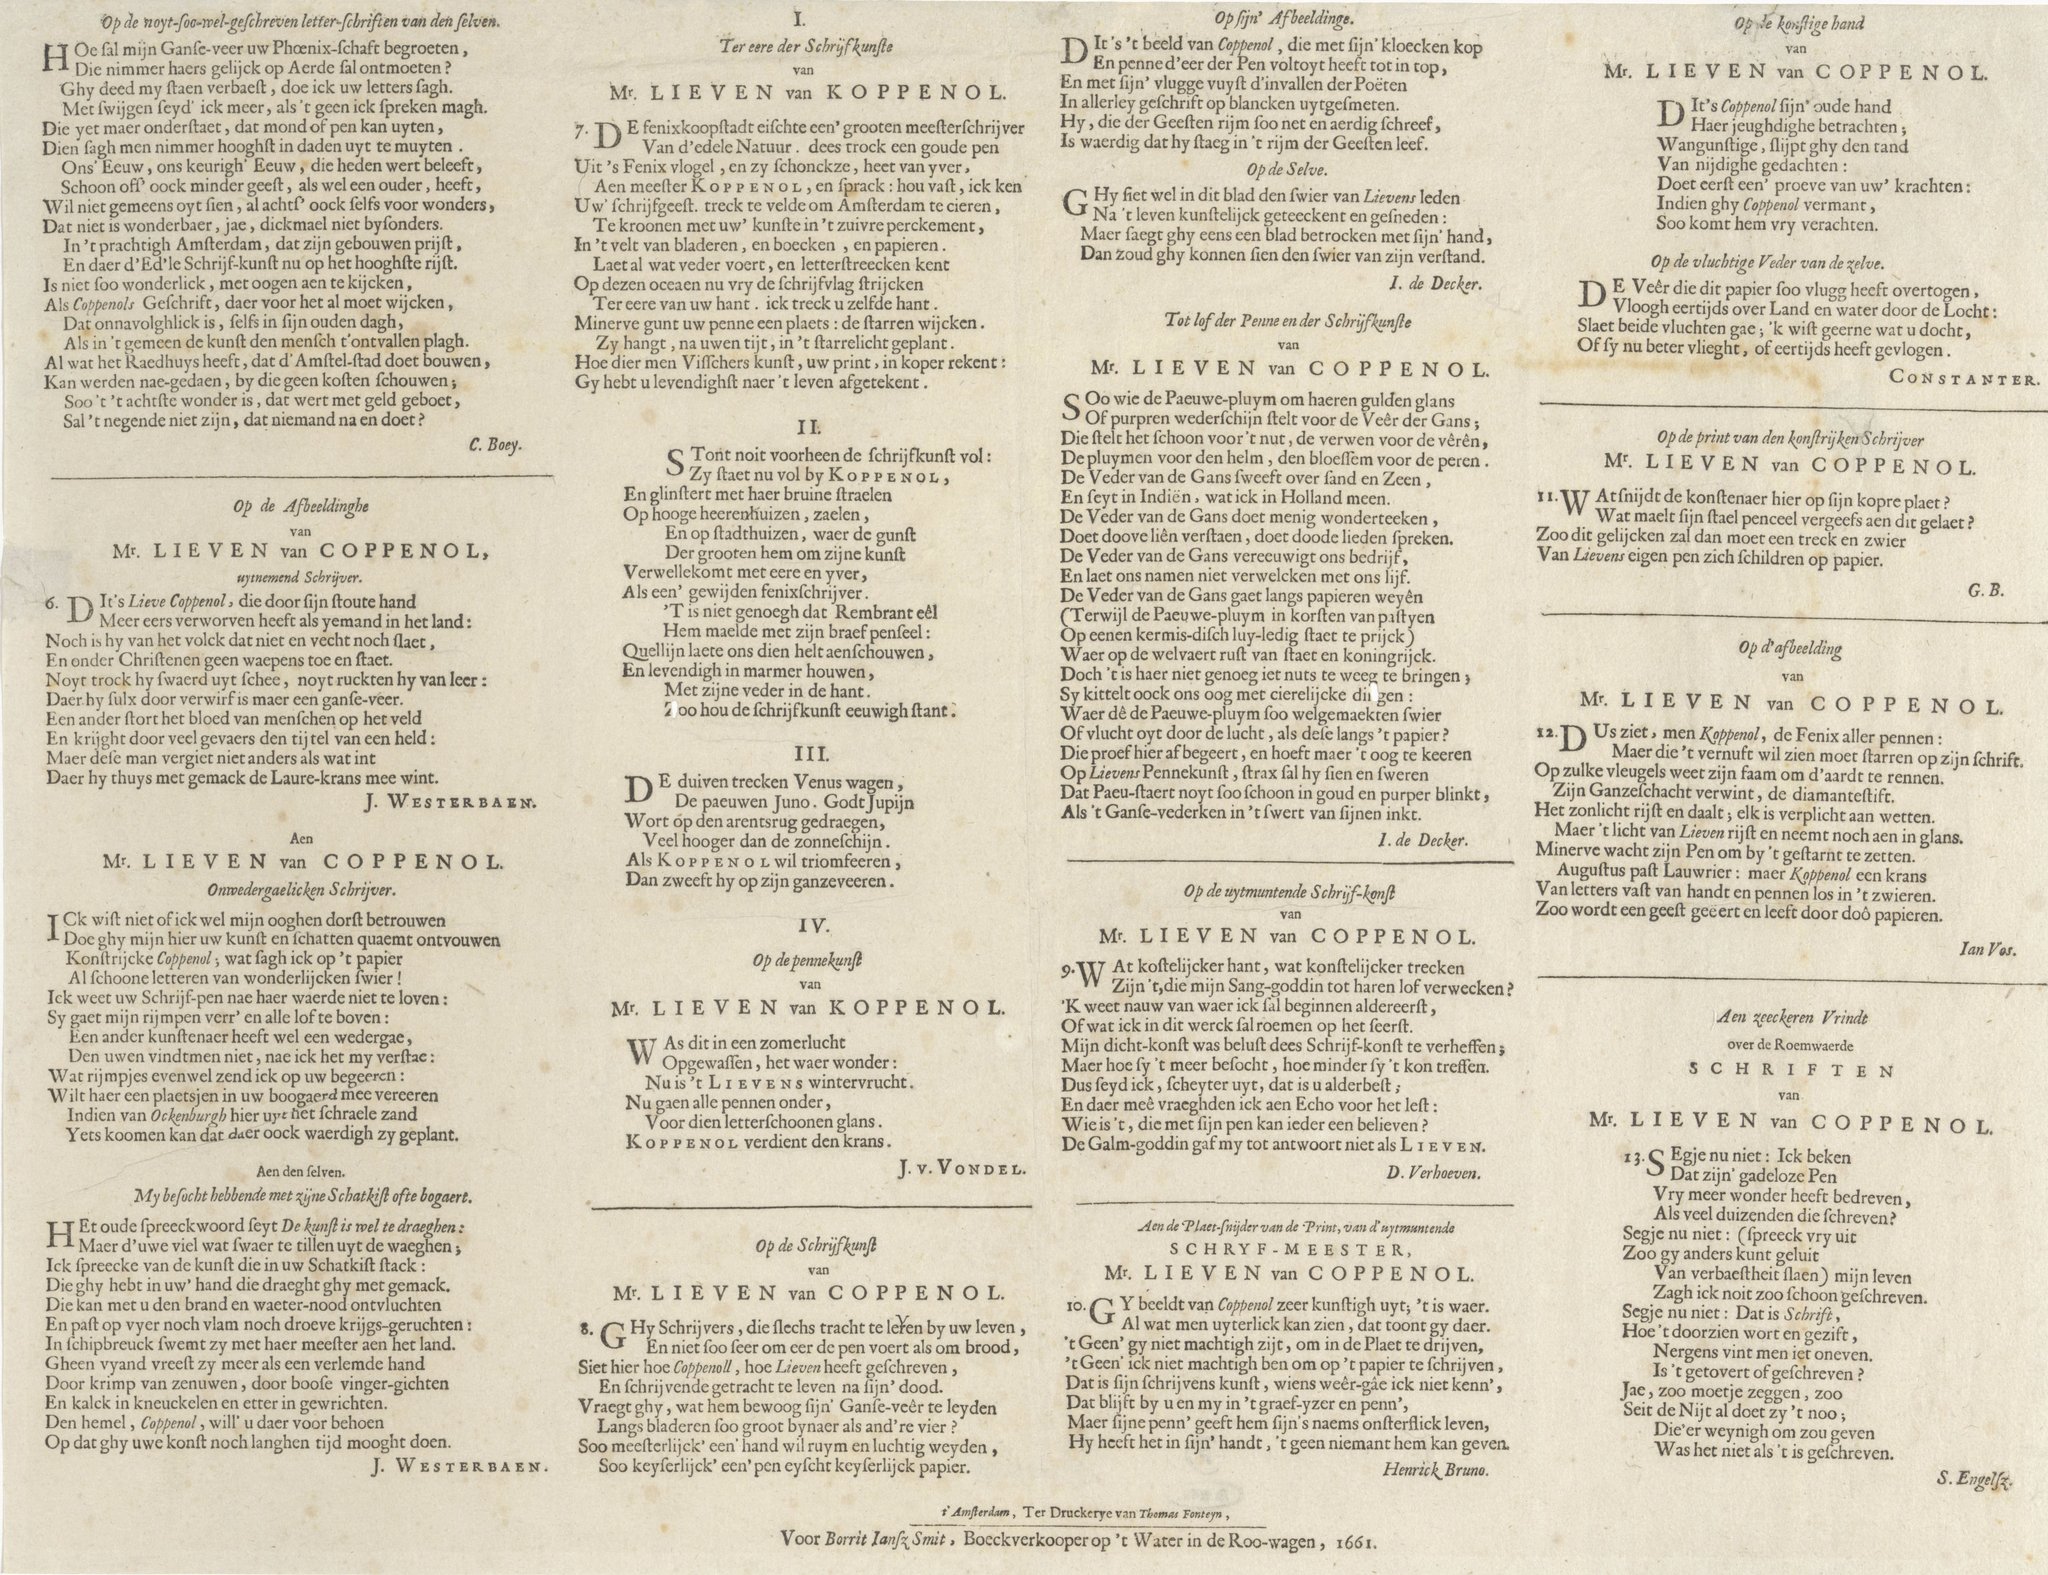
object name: text sheet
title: Lofgedichten van diverse schrijvers op Lieven Willemsz. van Coppenol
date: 1661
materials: paper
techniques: letterpress printing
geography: amsterdam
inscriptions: collector's mark: Lugt 964